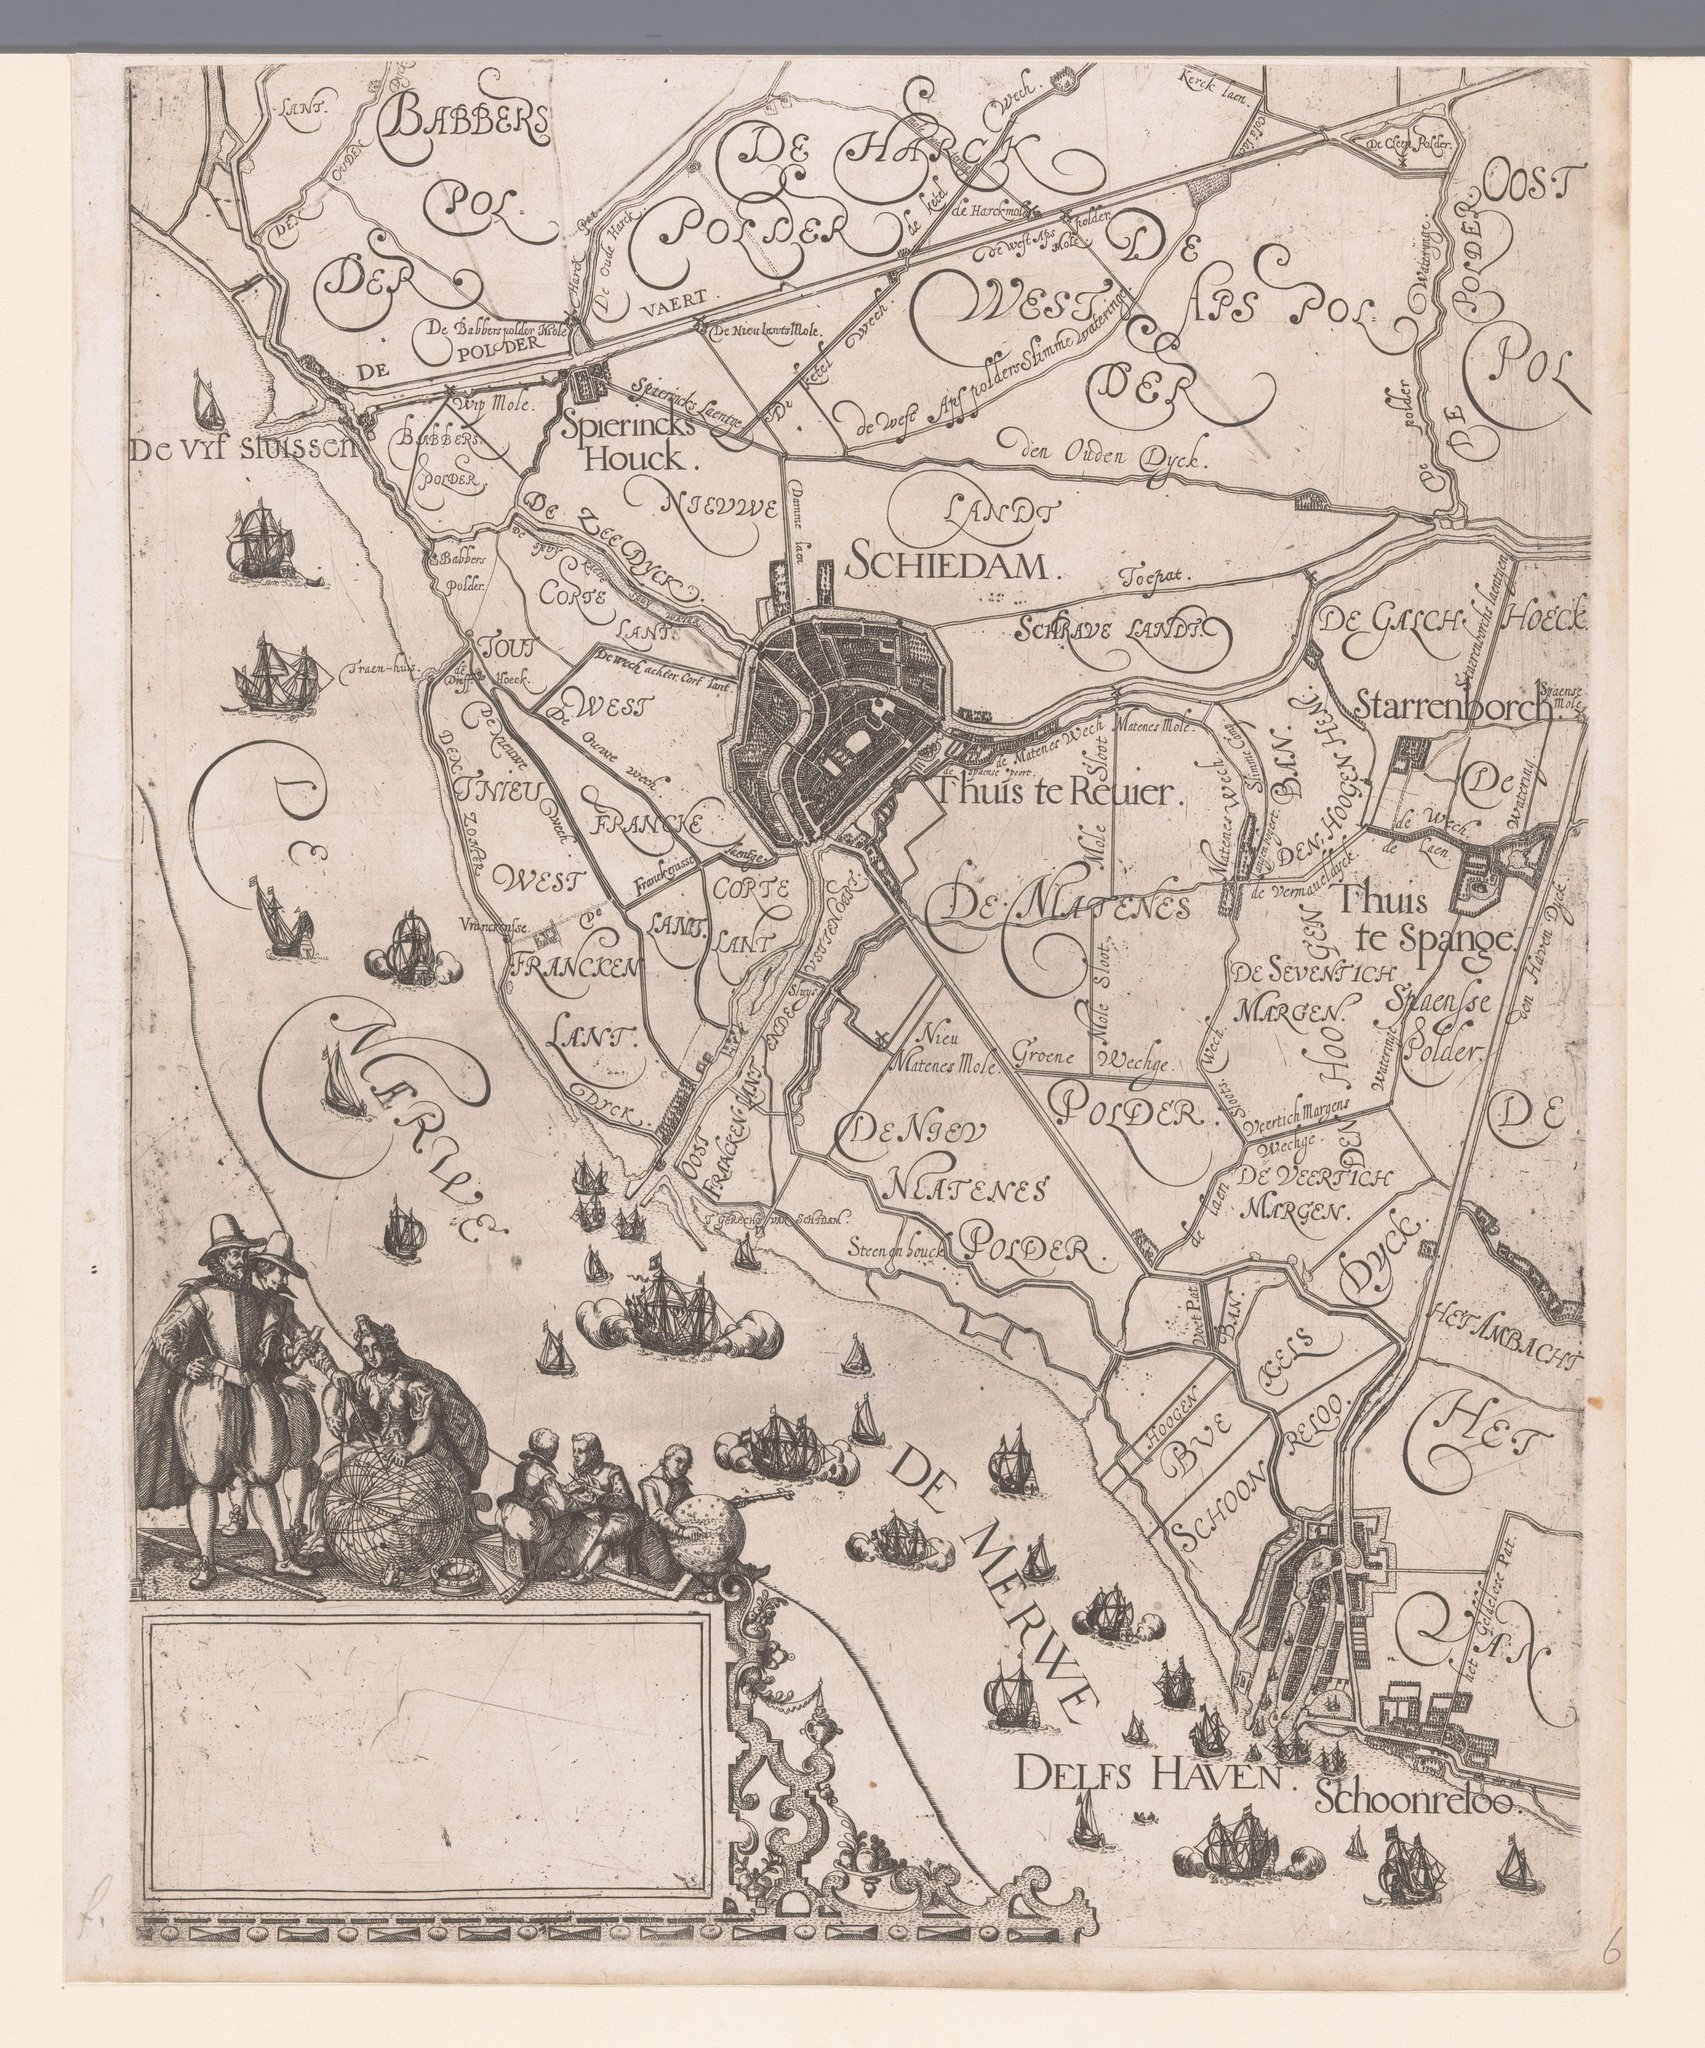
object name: map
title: Kaart van het Hoogheemraadschap van Schieland, met Schiedam en Delfshaven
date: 1611-1635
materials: paper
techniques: engraving, etching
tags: maps of separate countries or regions, armorial bearing, heraldry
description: Deze kaart is tussen 1611 en 1635 vijf keer uitgegeven zonder dat de platen zijn bijgewerkt. Onduidelijk tot welke uitgave dit exemplaar behoort.